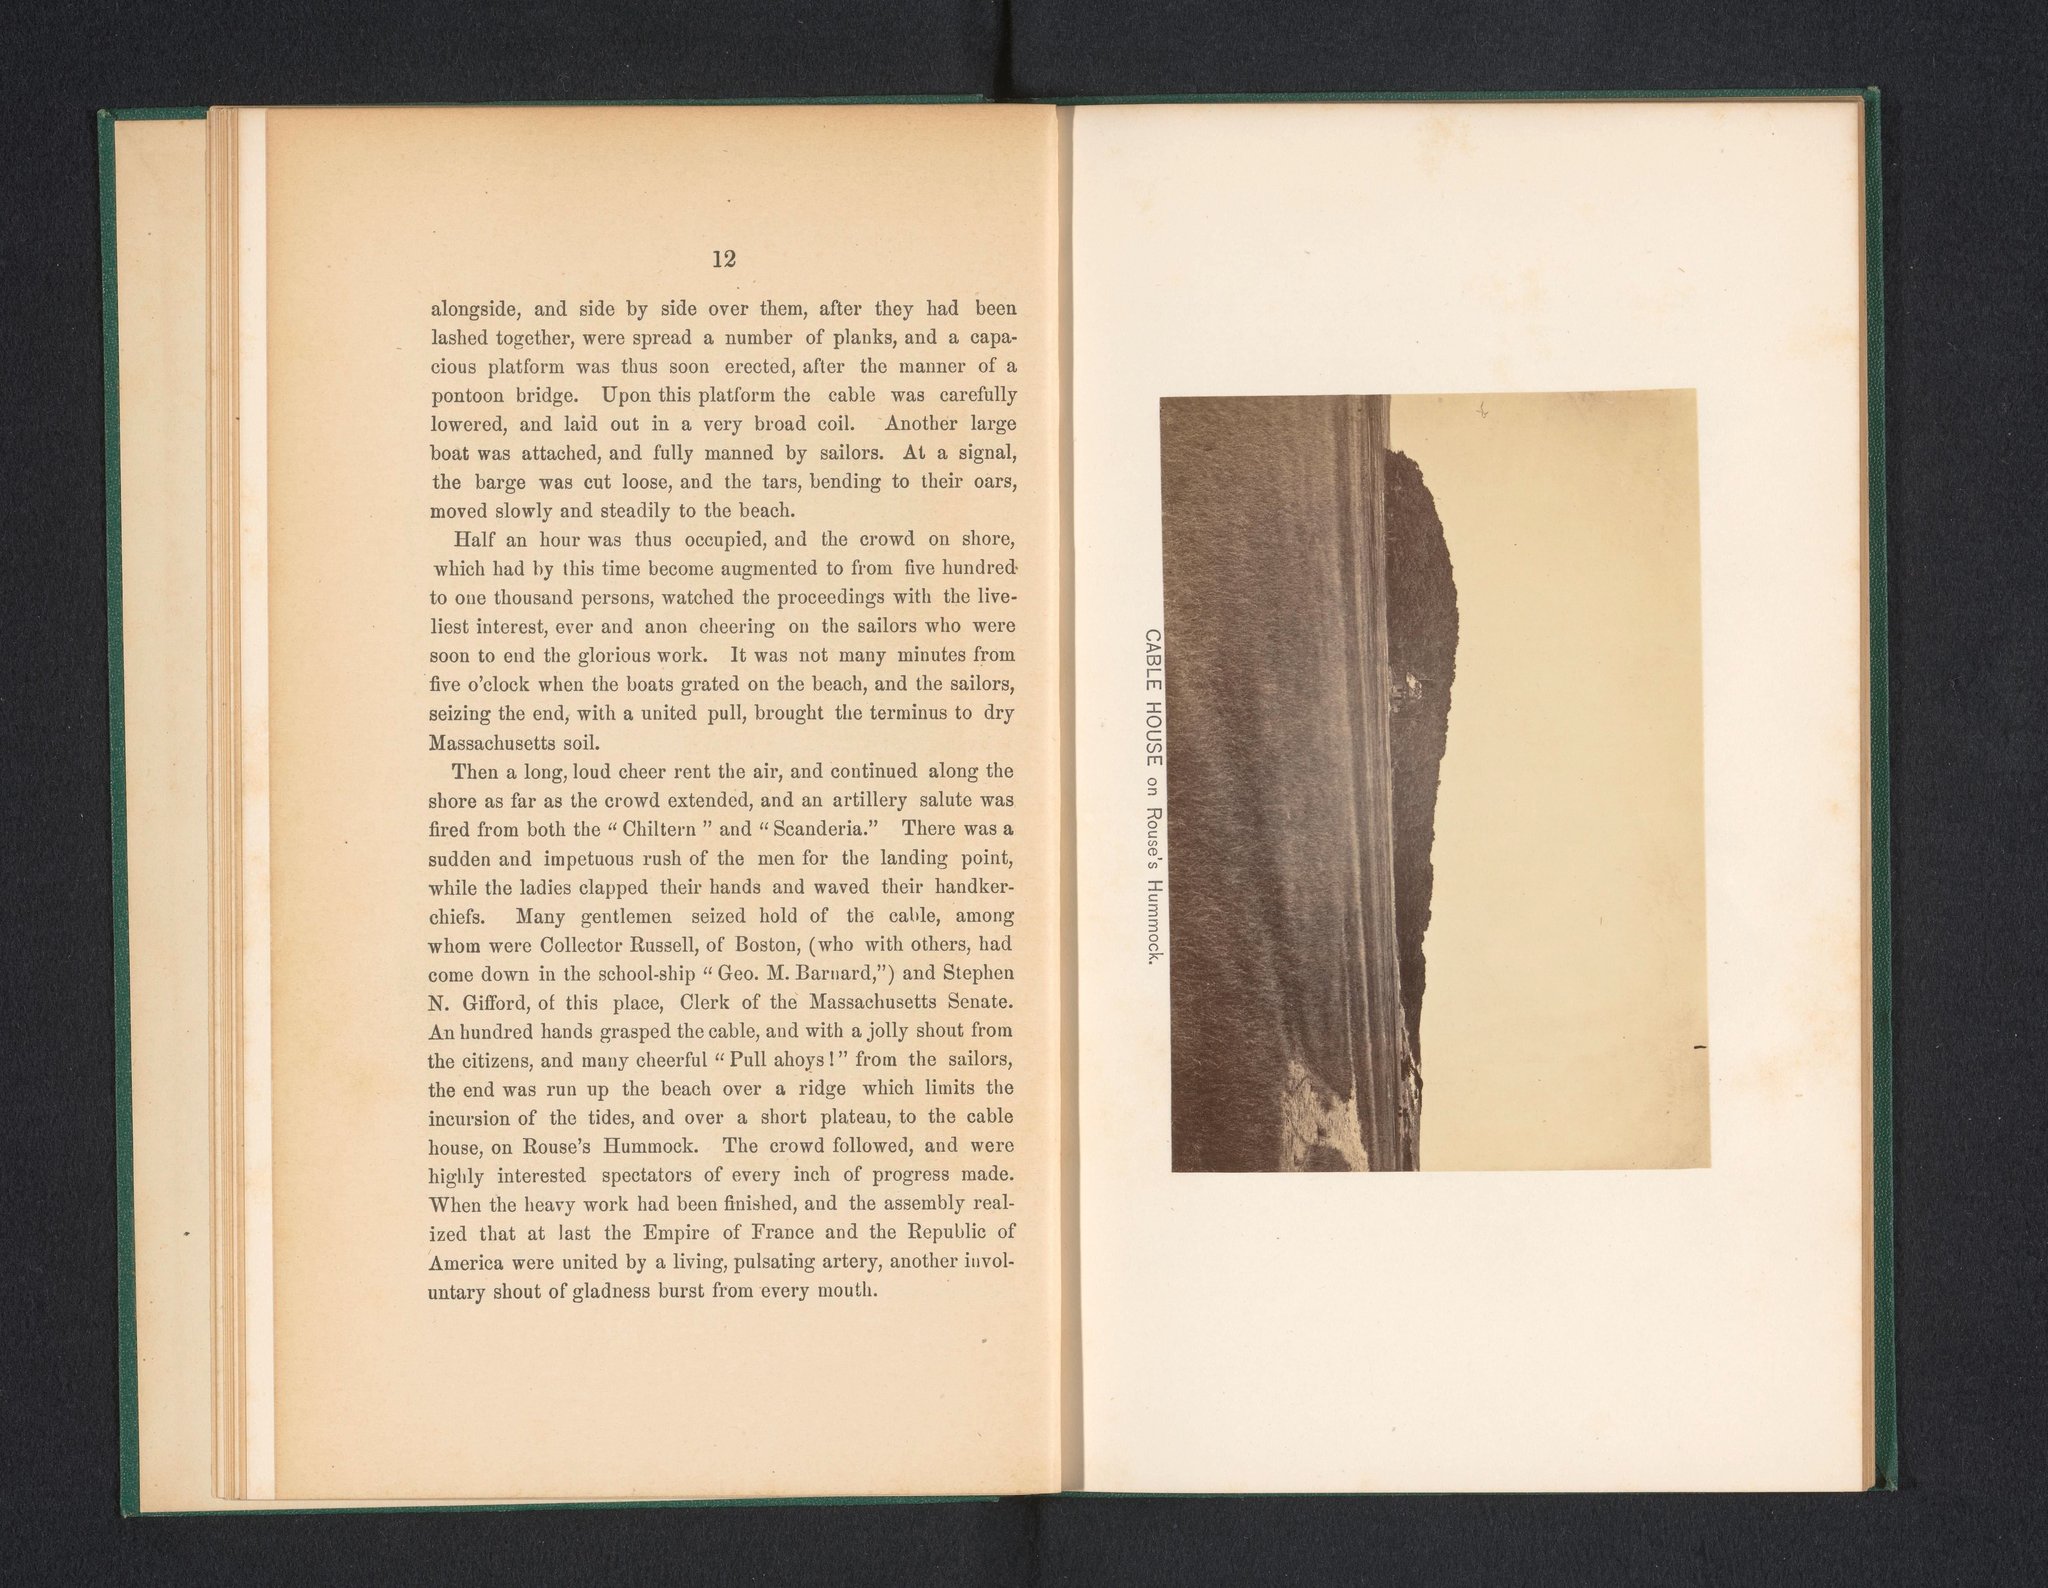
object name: page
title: Cable house on Rouse's Hummock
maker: Anonymous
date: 1869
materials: photographic support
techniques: albumen print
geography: duxbury beach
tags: landscapes, country-house